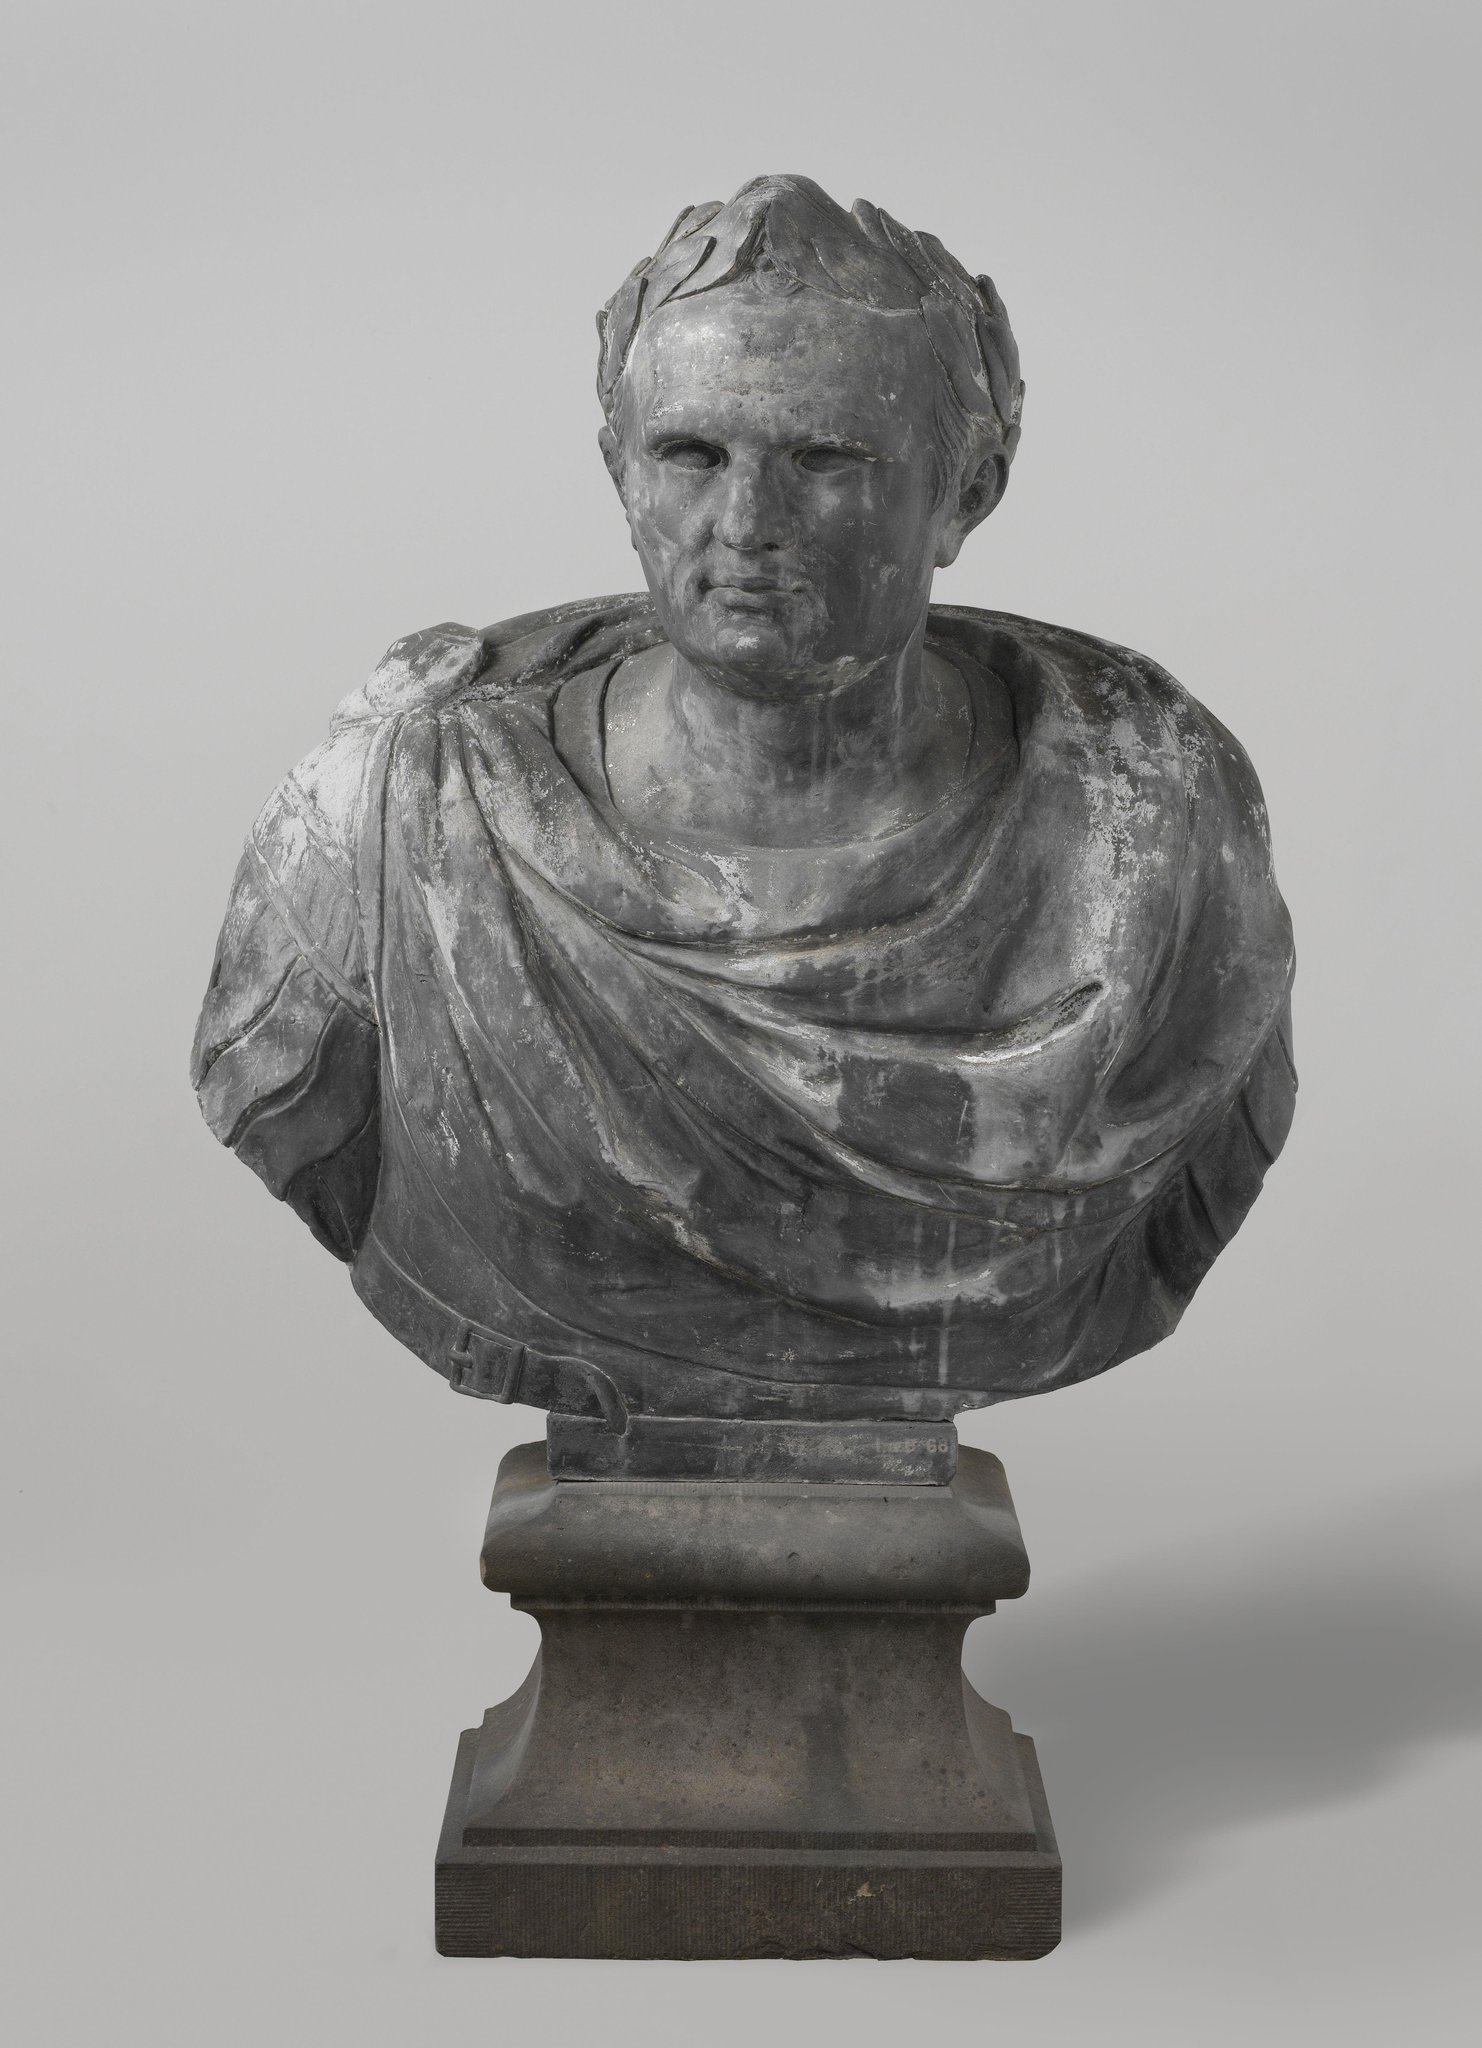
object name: tuinbeeld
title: Julius Caesar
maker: barent dronrijp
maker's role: caster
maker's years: 1660-1705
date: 1674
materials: lead, stone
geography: amsterdam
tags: rome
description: The series of twelve marble busts from which these four figures were cast represented the first twelve emperors of Rome. Although the Dutch word ‘keizer’ derives from Caesar’s name, he was never an emperor. His adoptive son Augustus was the first Roman emperor. Yet because Caesar had assumed absolute power, he is generally included in the series.